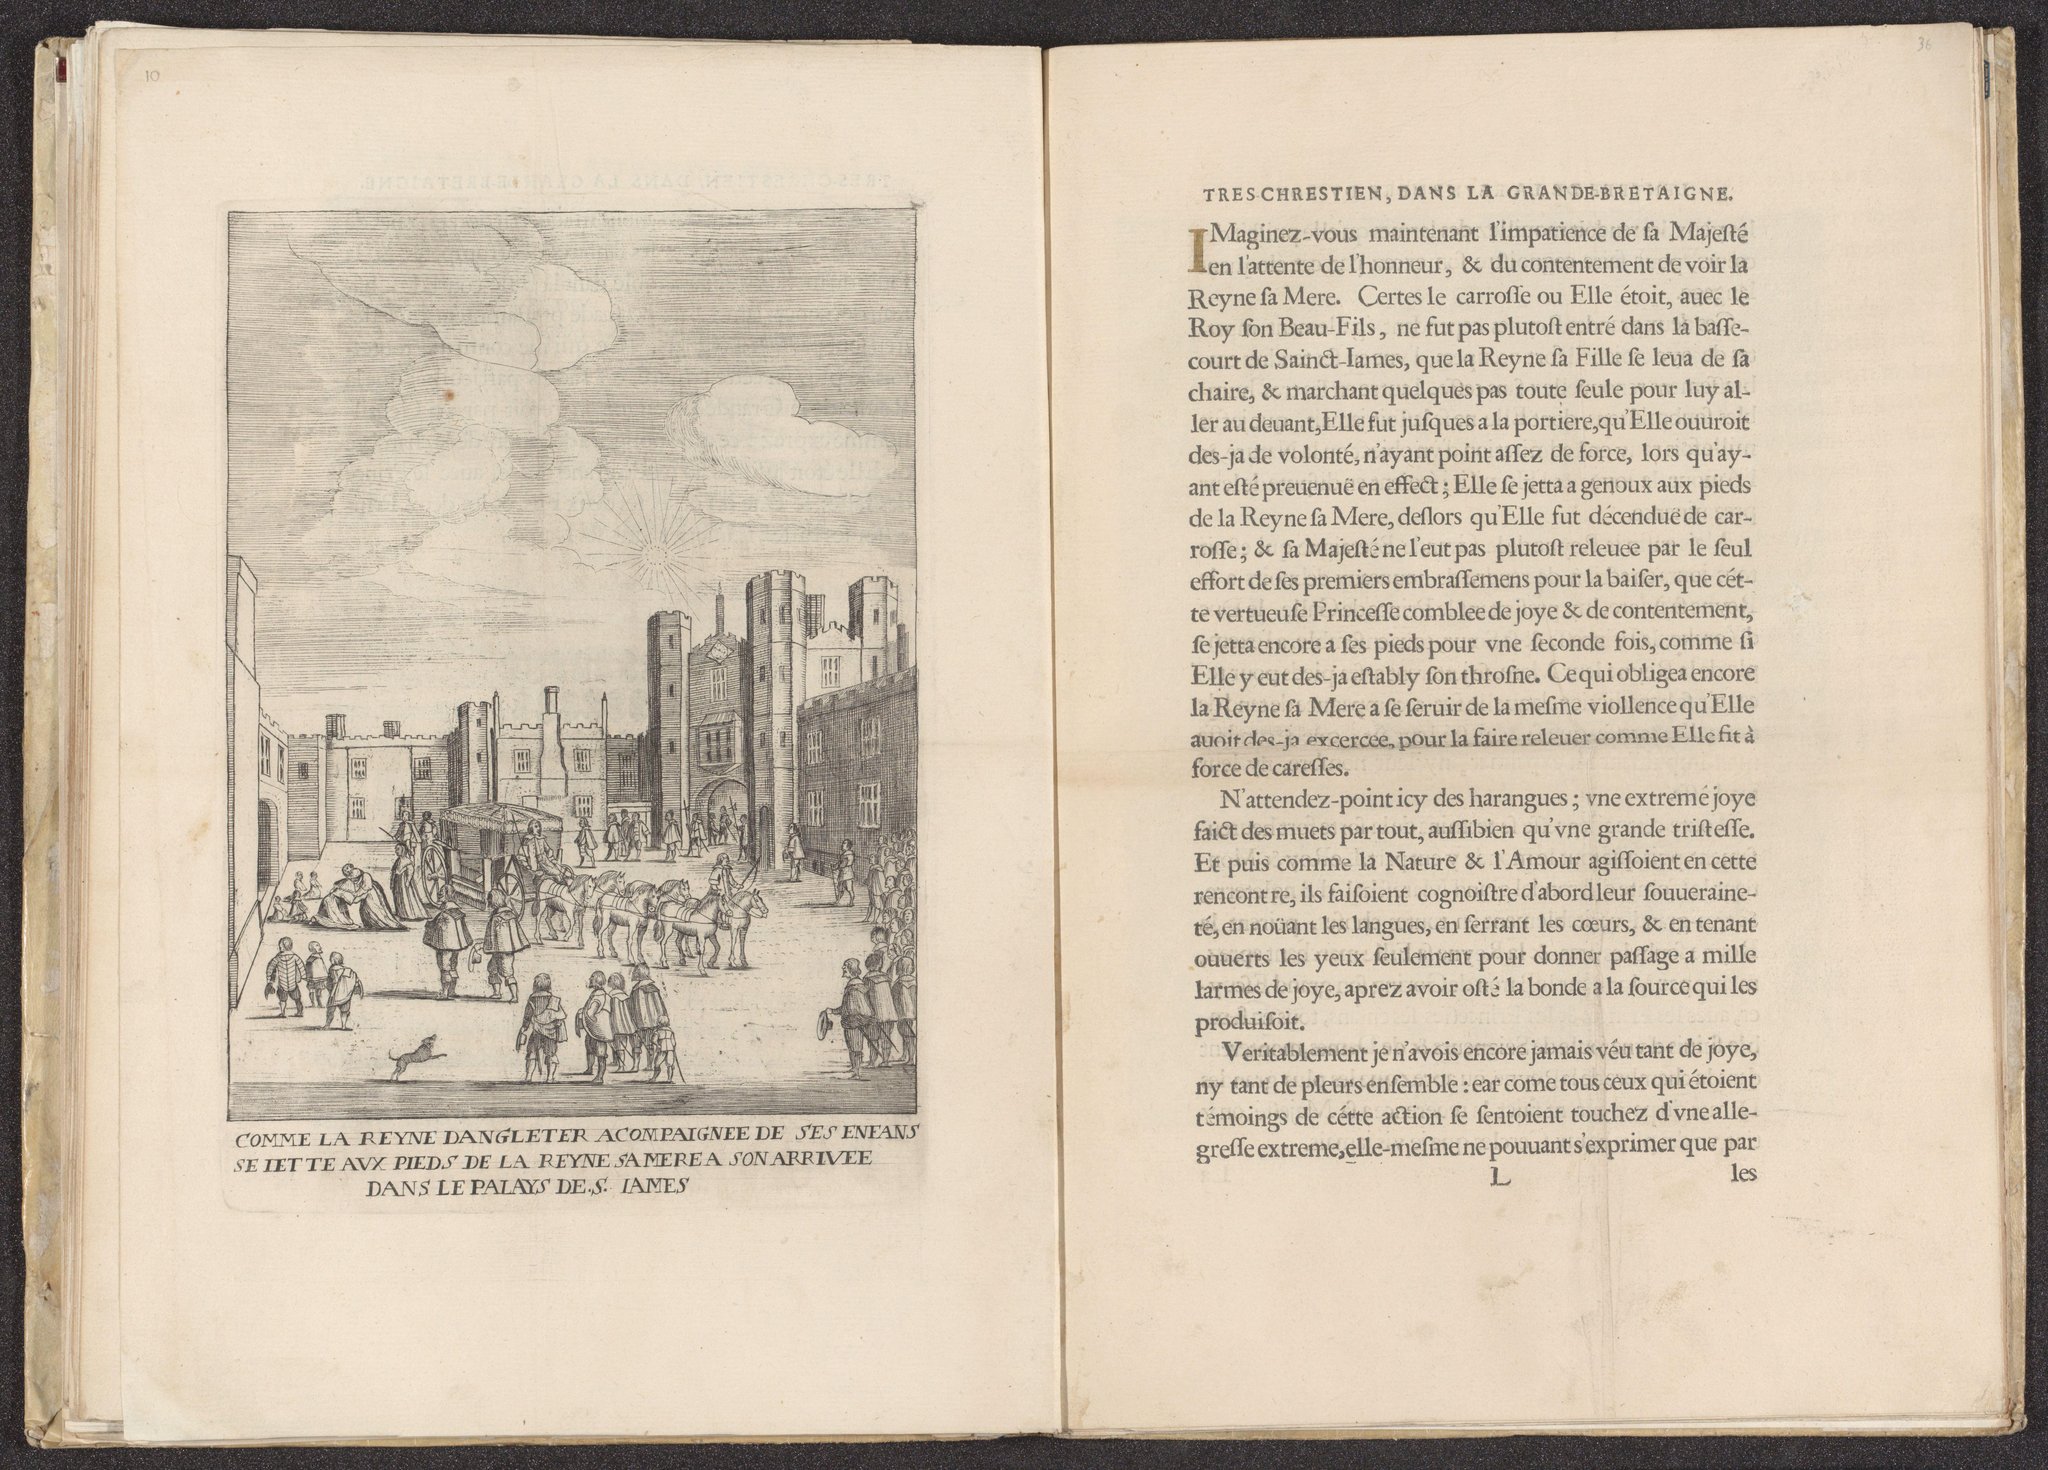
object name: history print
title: Comme la reyne dangleter acompaignee de ses enfans se jette aux pieds de la reyne sa mere a son arrivee dans le palays de S. James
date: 1639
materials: paper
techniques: etching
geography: london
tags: cologne, print maker, maria de' medici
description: Henrietta Maria omhelst Maria de' Medici, haar moeder, op de binnenplaats van St James' Palace. Op de binnenplaats staat een koets met paarden en verschillende mensen kijken toe. De prent maakt deel uit van een boek over de ontvangst van de Franse koning-moeder Maria de' Medici aan Engeland.